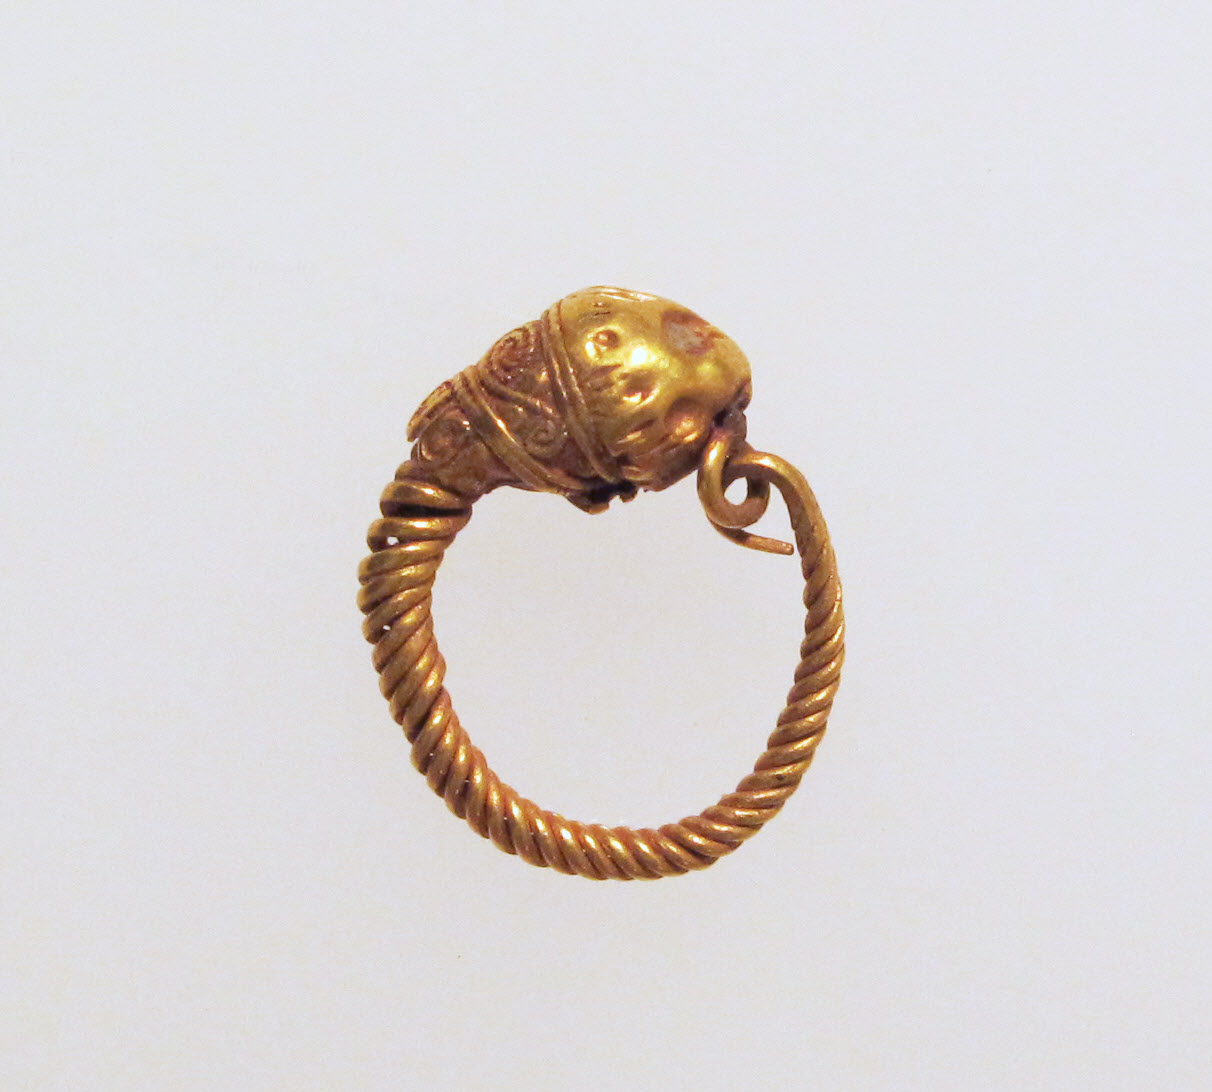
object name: earring with head of lion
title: Gold earring with head of a lion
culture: greek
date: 400-201 BCE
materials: gold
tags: lions